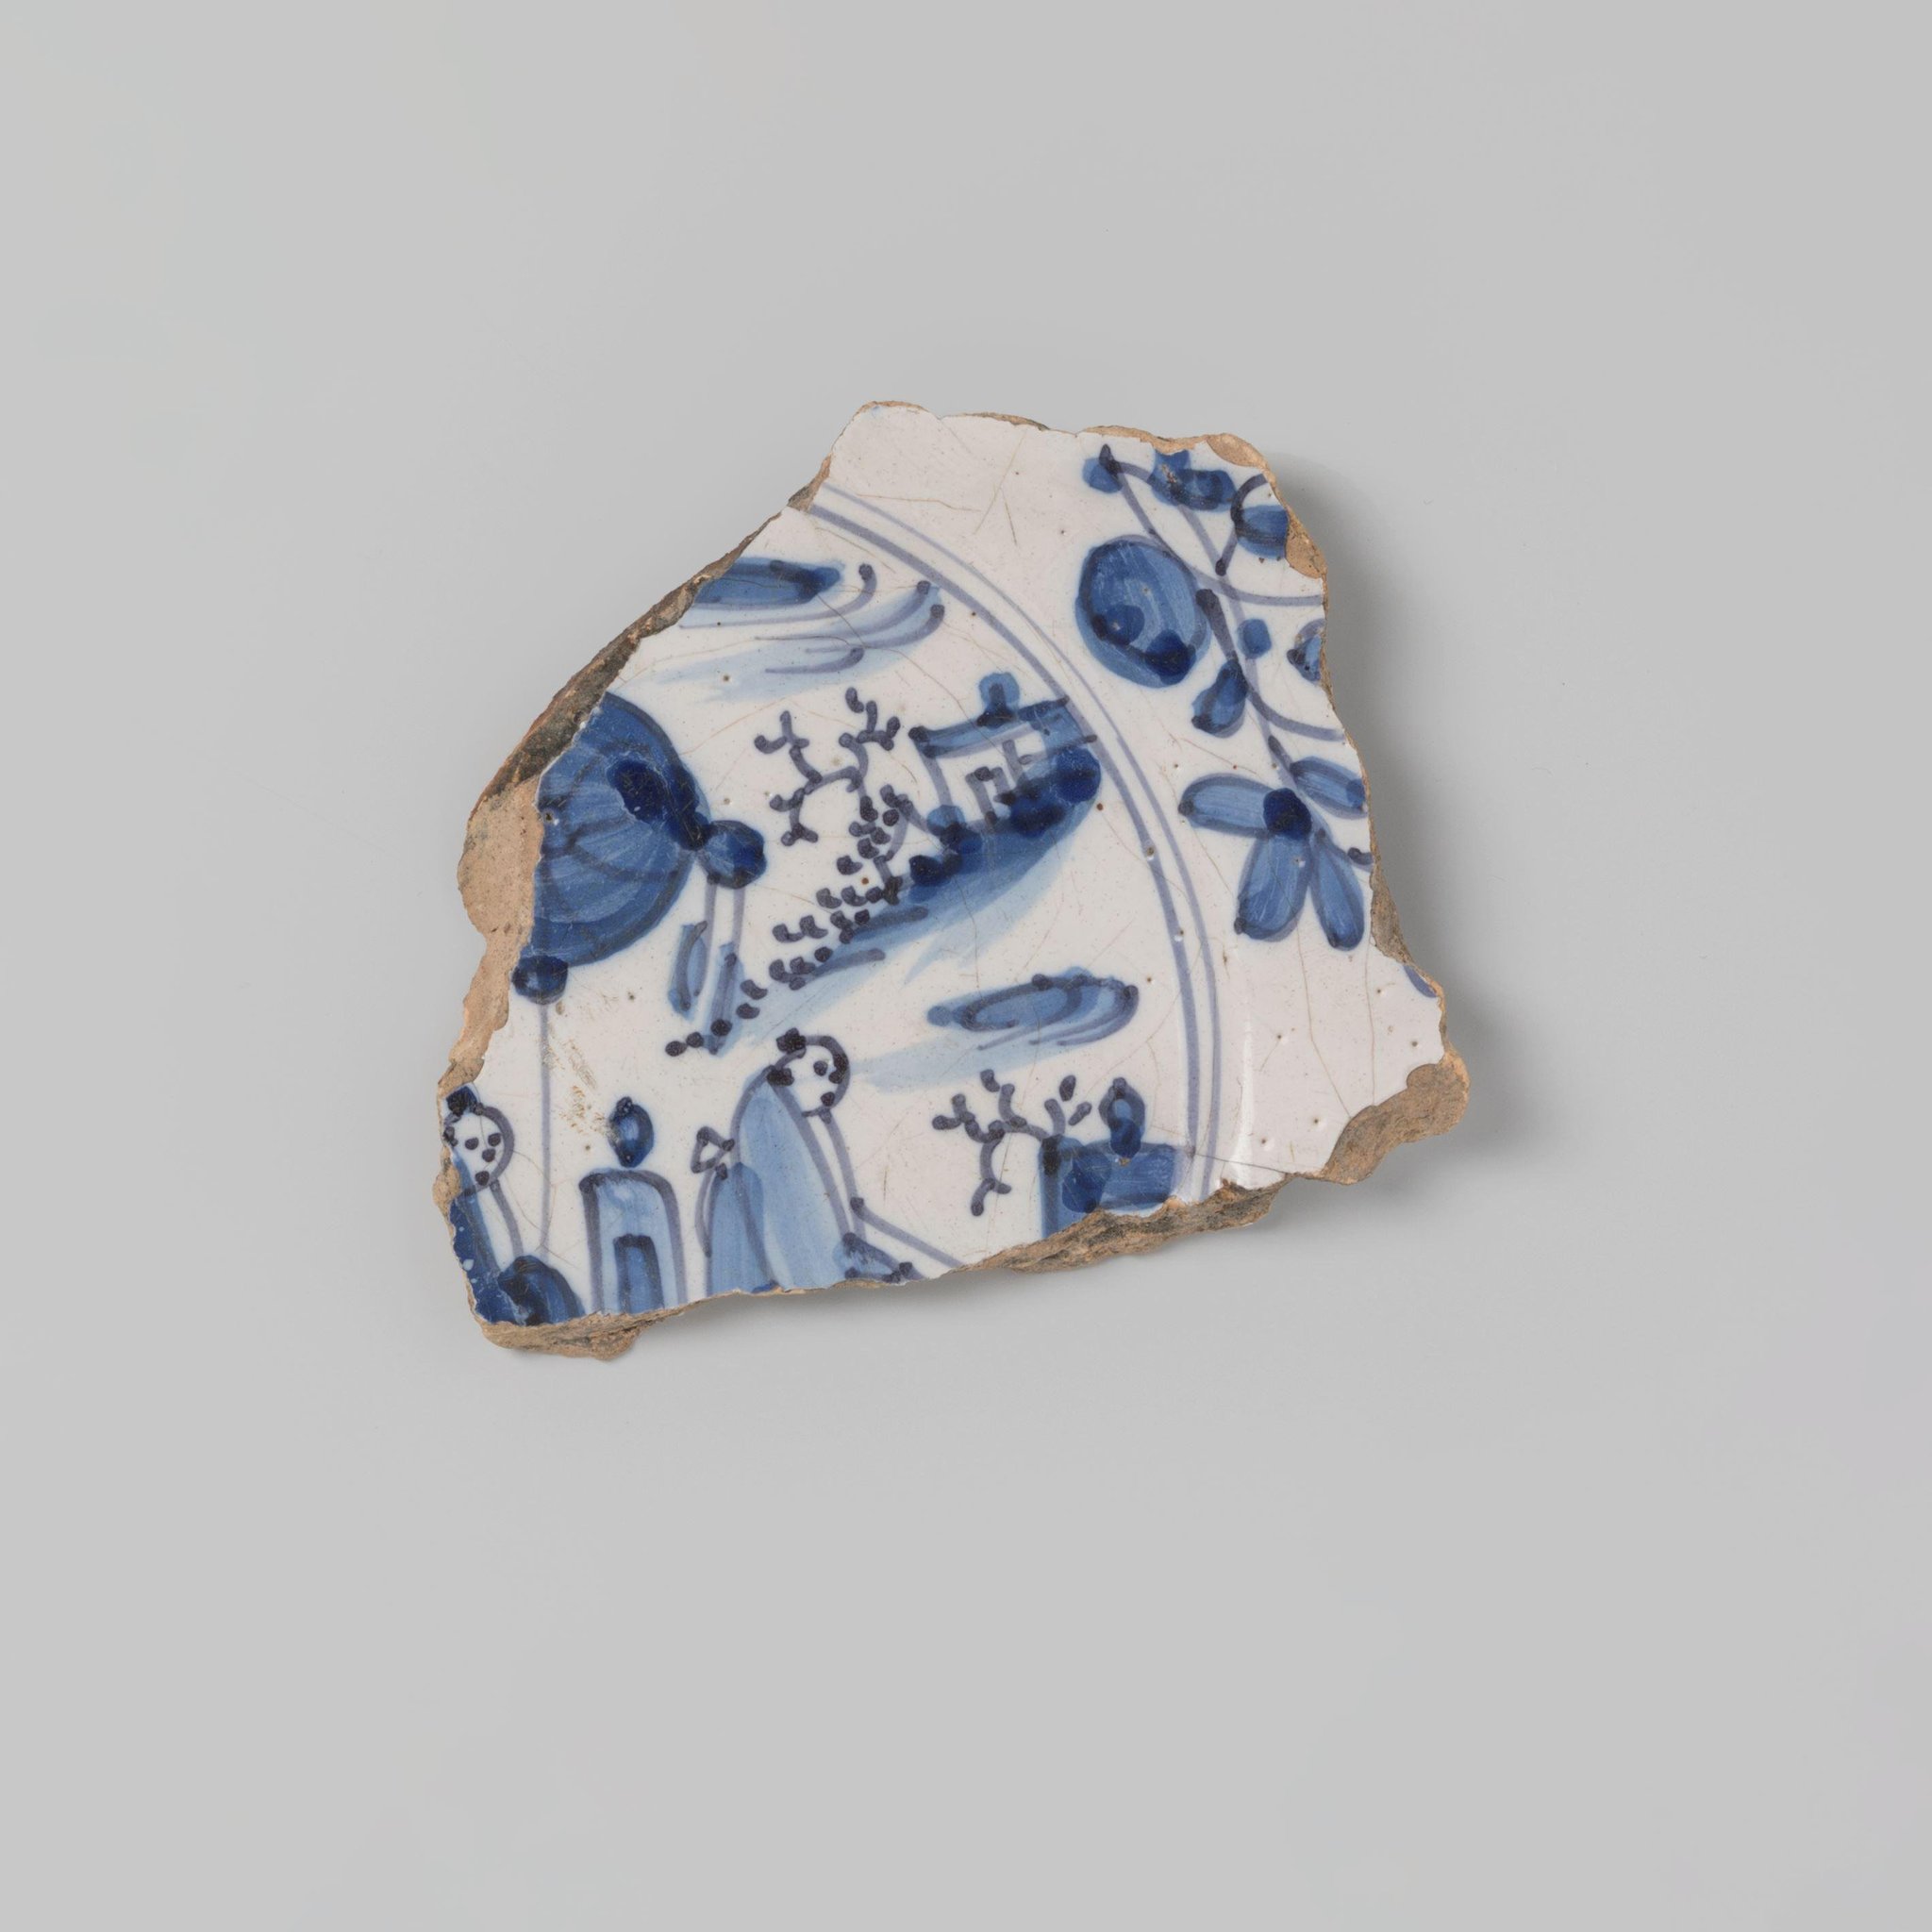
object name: sherd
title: Schotelscherf van aardewerk voorzien van een tekening van een landschap met personen, in onderglazuur blauw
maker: Anonymous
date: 1500-1799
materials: earthenware, glaze